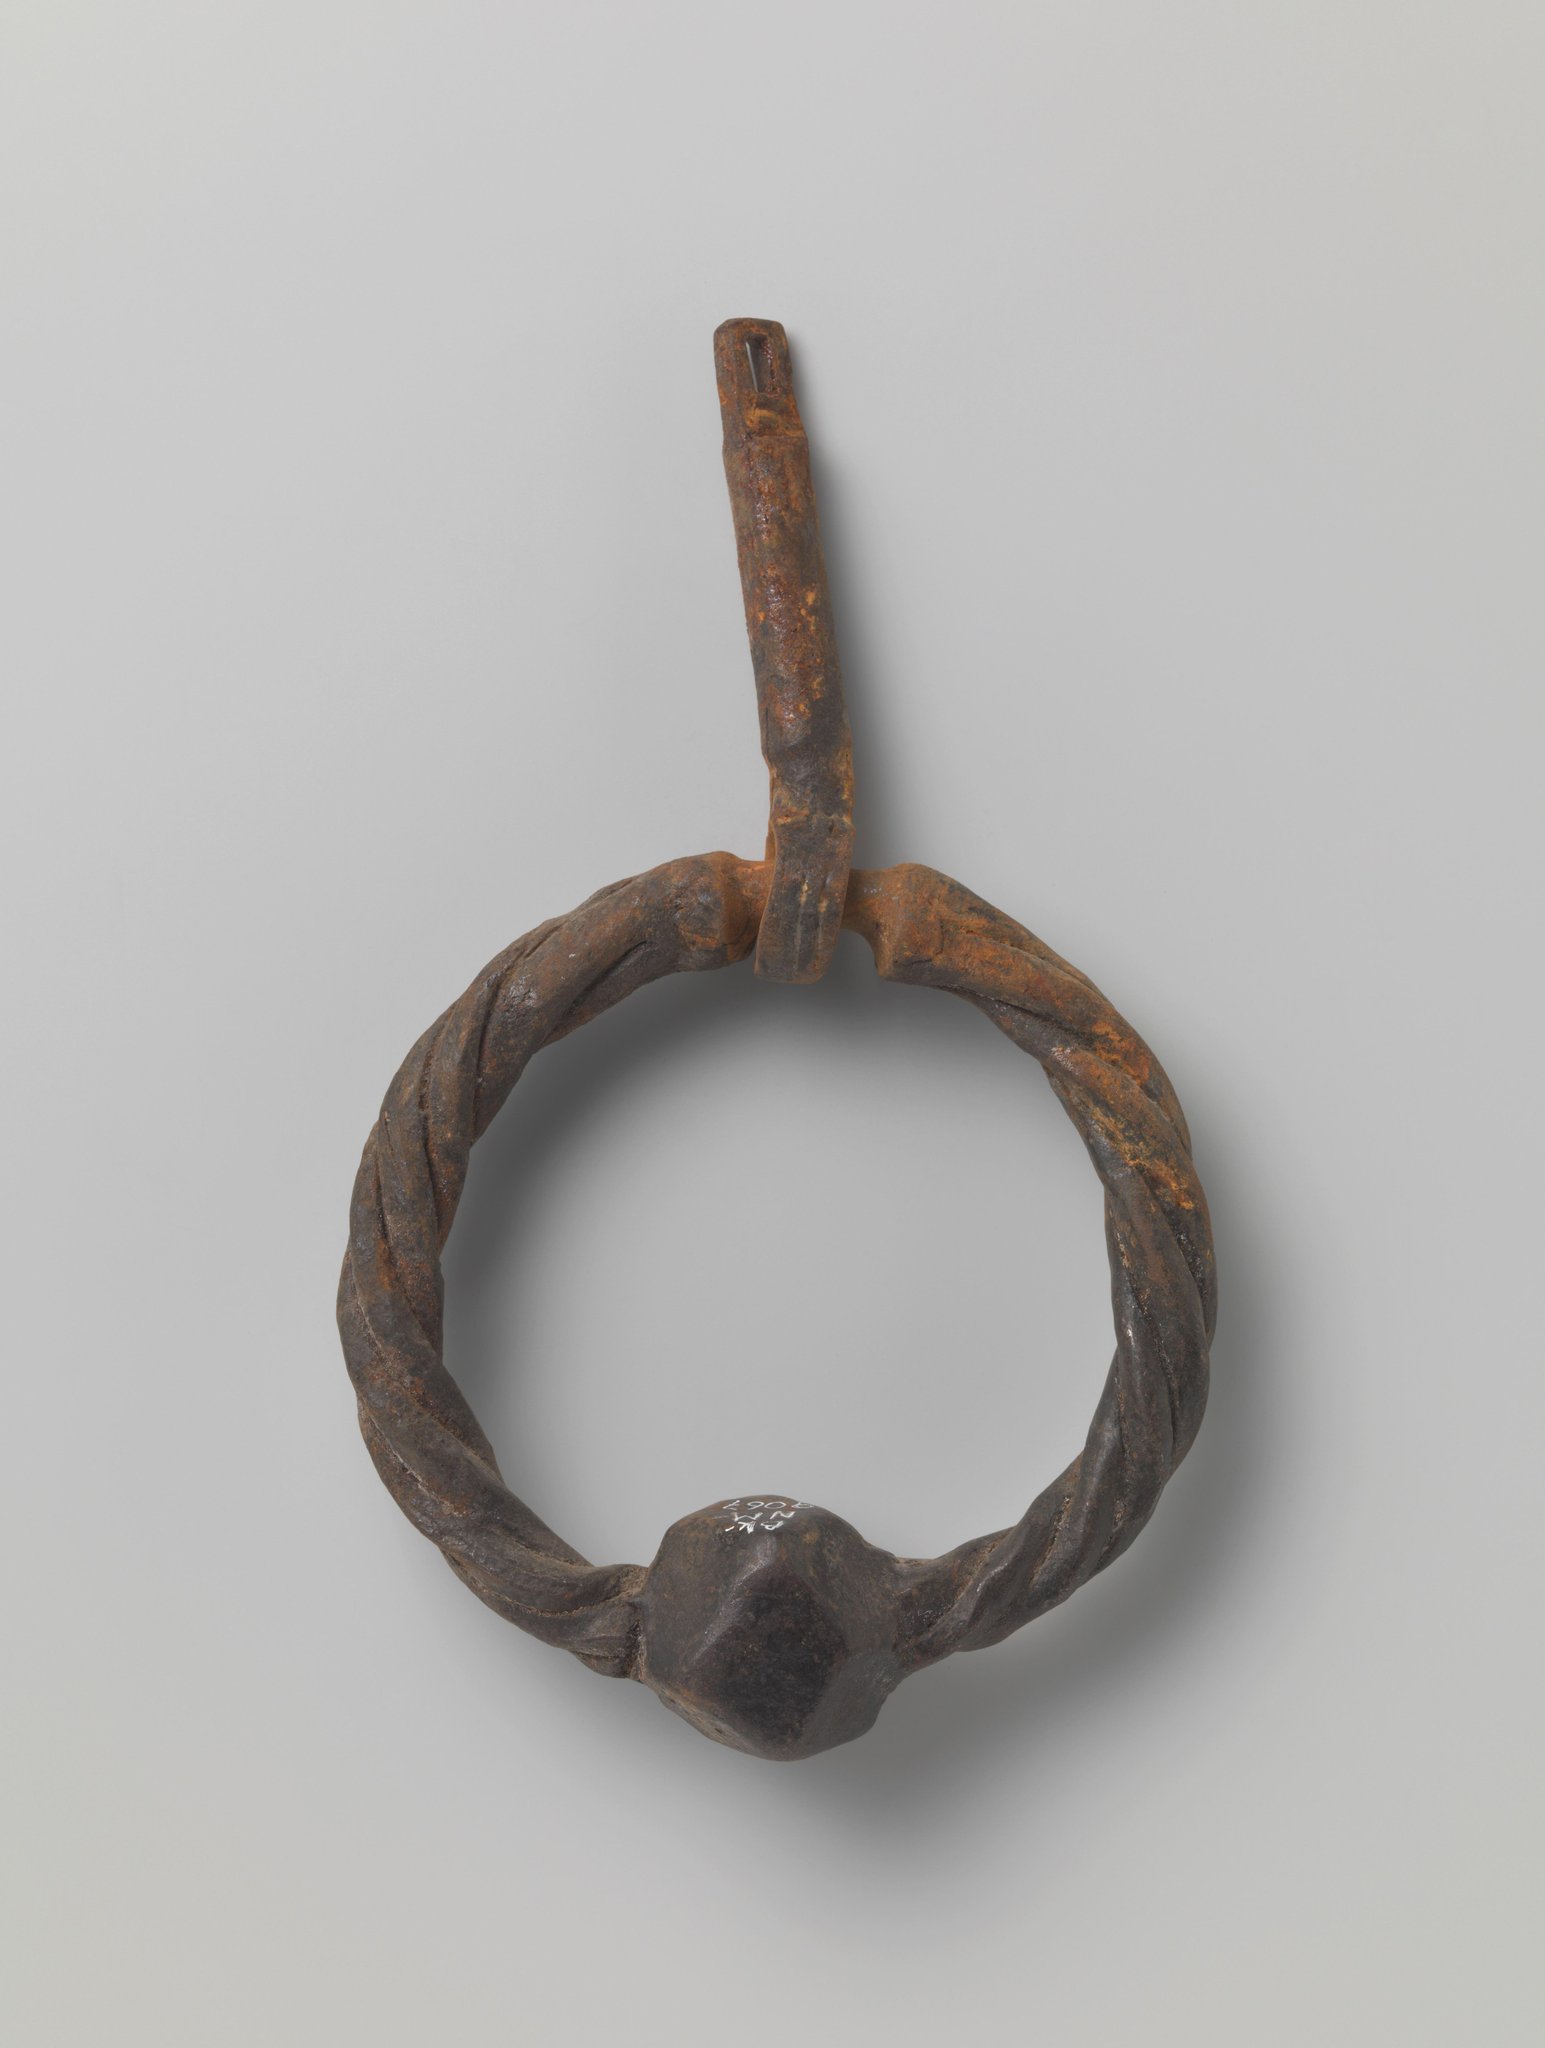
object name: door knocker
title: Deurklopper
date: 1400-1950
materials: iron